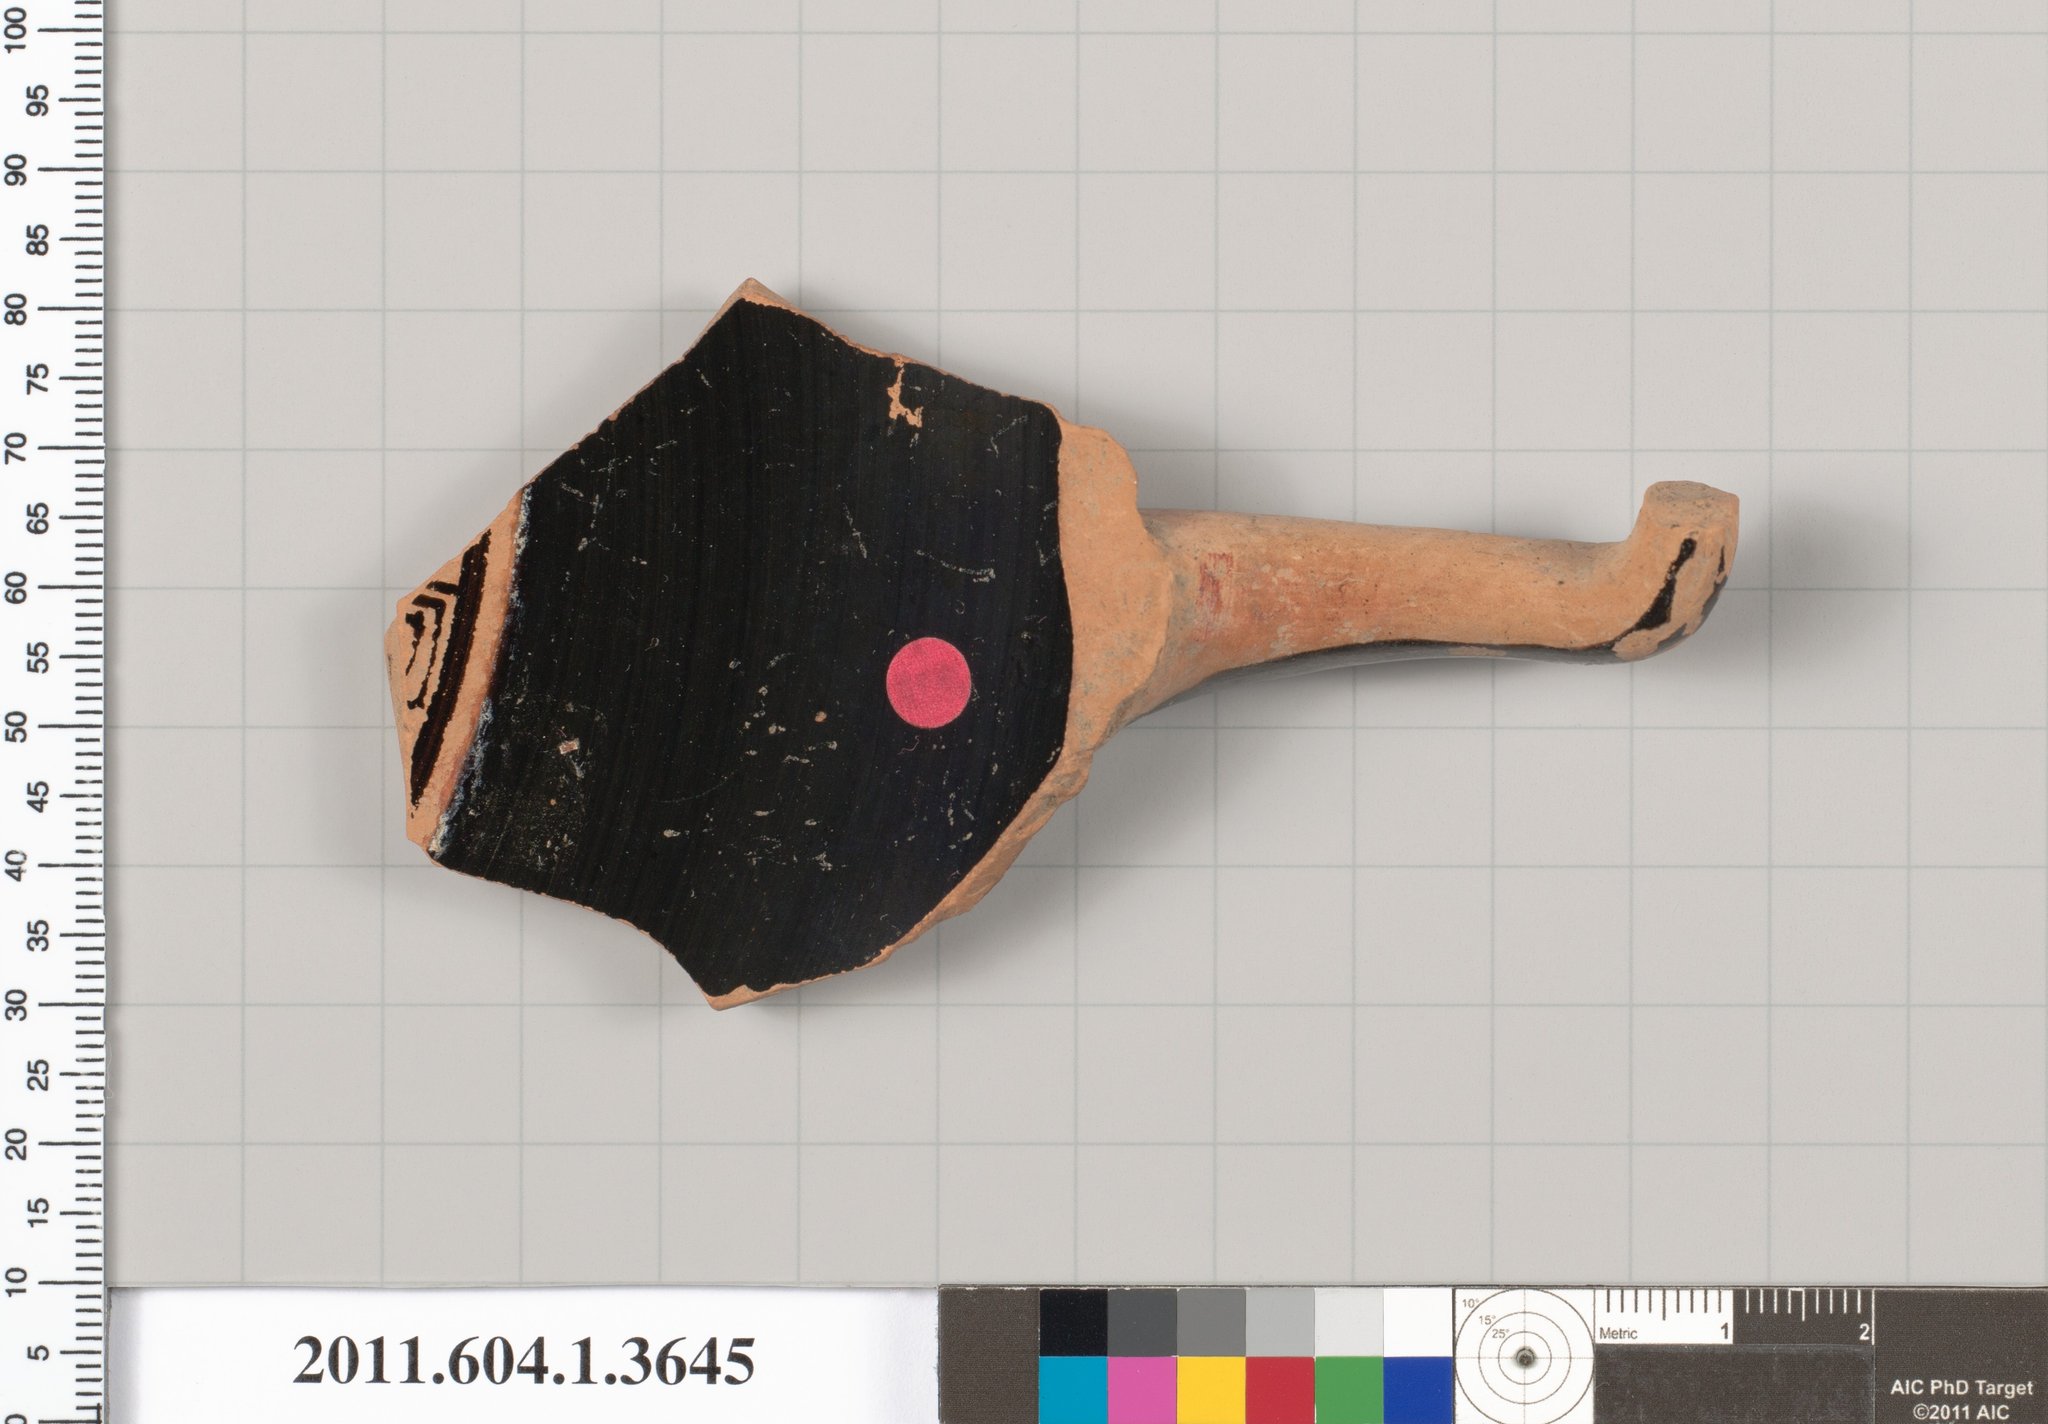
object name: kylix fragment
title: Terracotta fragment of a kylix (drinking cup)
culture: greek, attic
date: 475-451 BCE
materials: terracotta